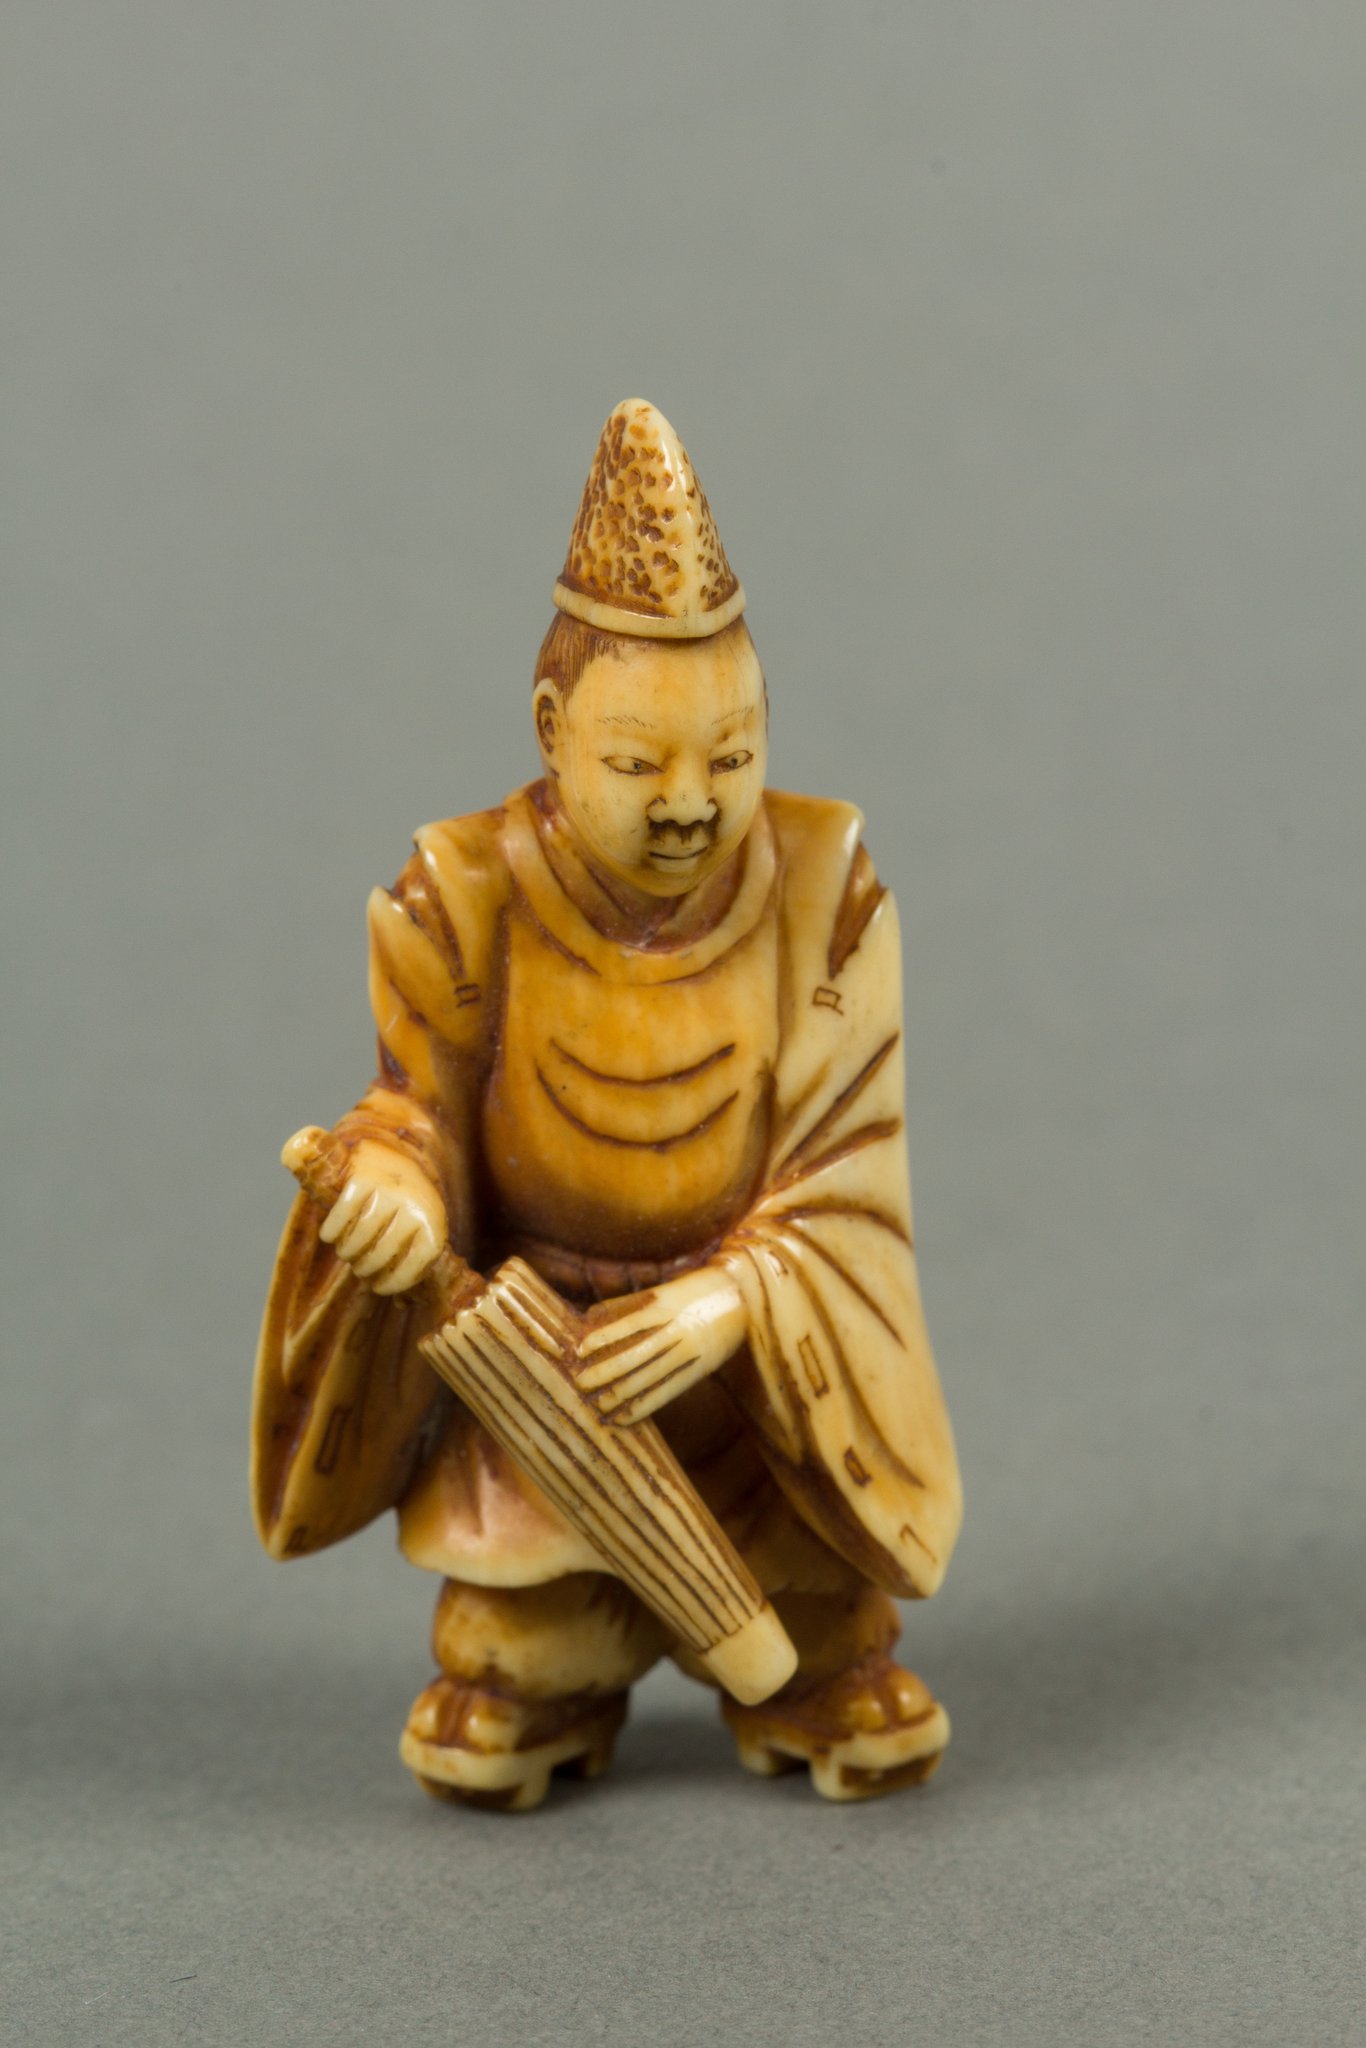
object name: netsuke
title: Netsuke of a Boy Carrying an Umbrella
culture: japanese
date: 1701-1800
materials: ivory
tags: boys